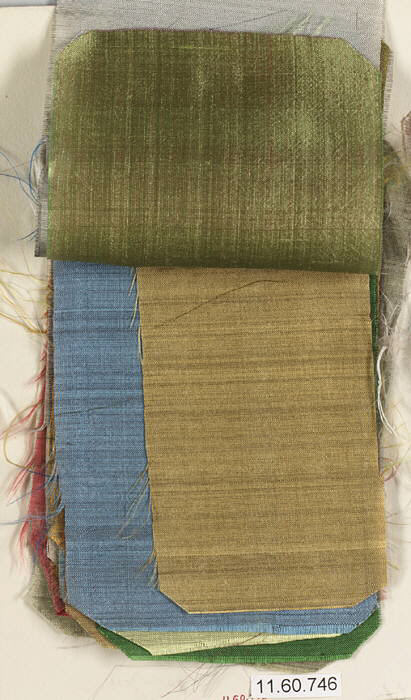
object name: sample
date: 1801-1833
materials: silk